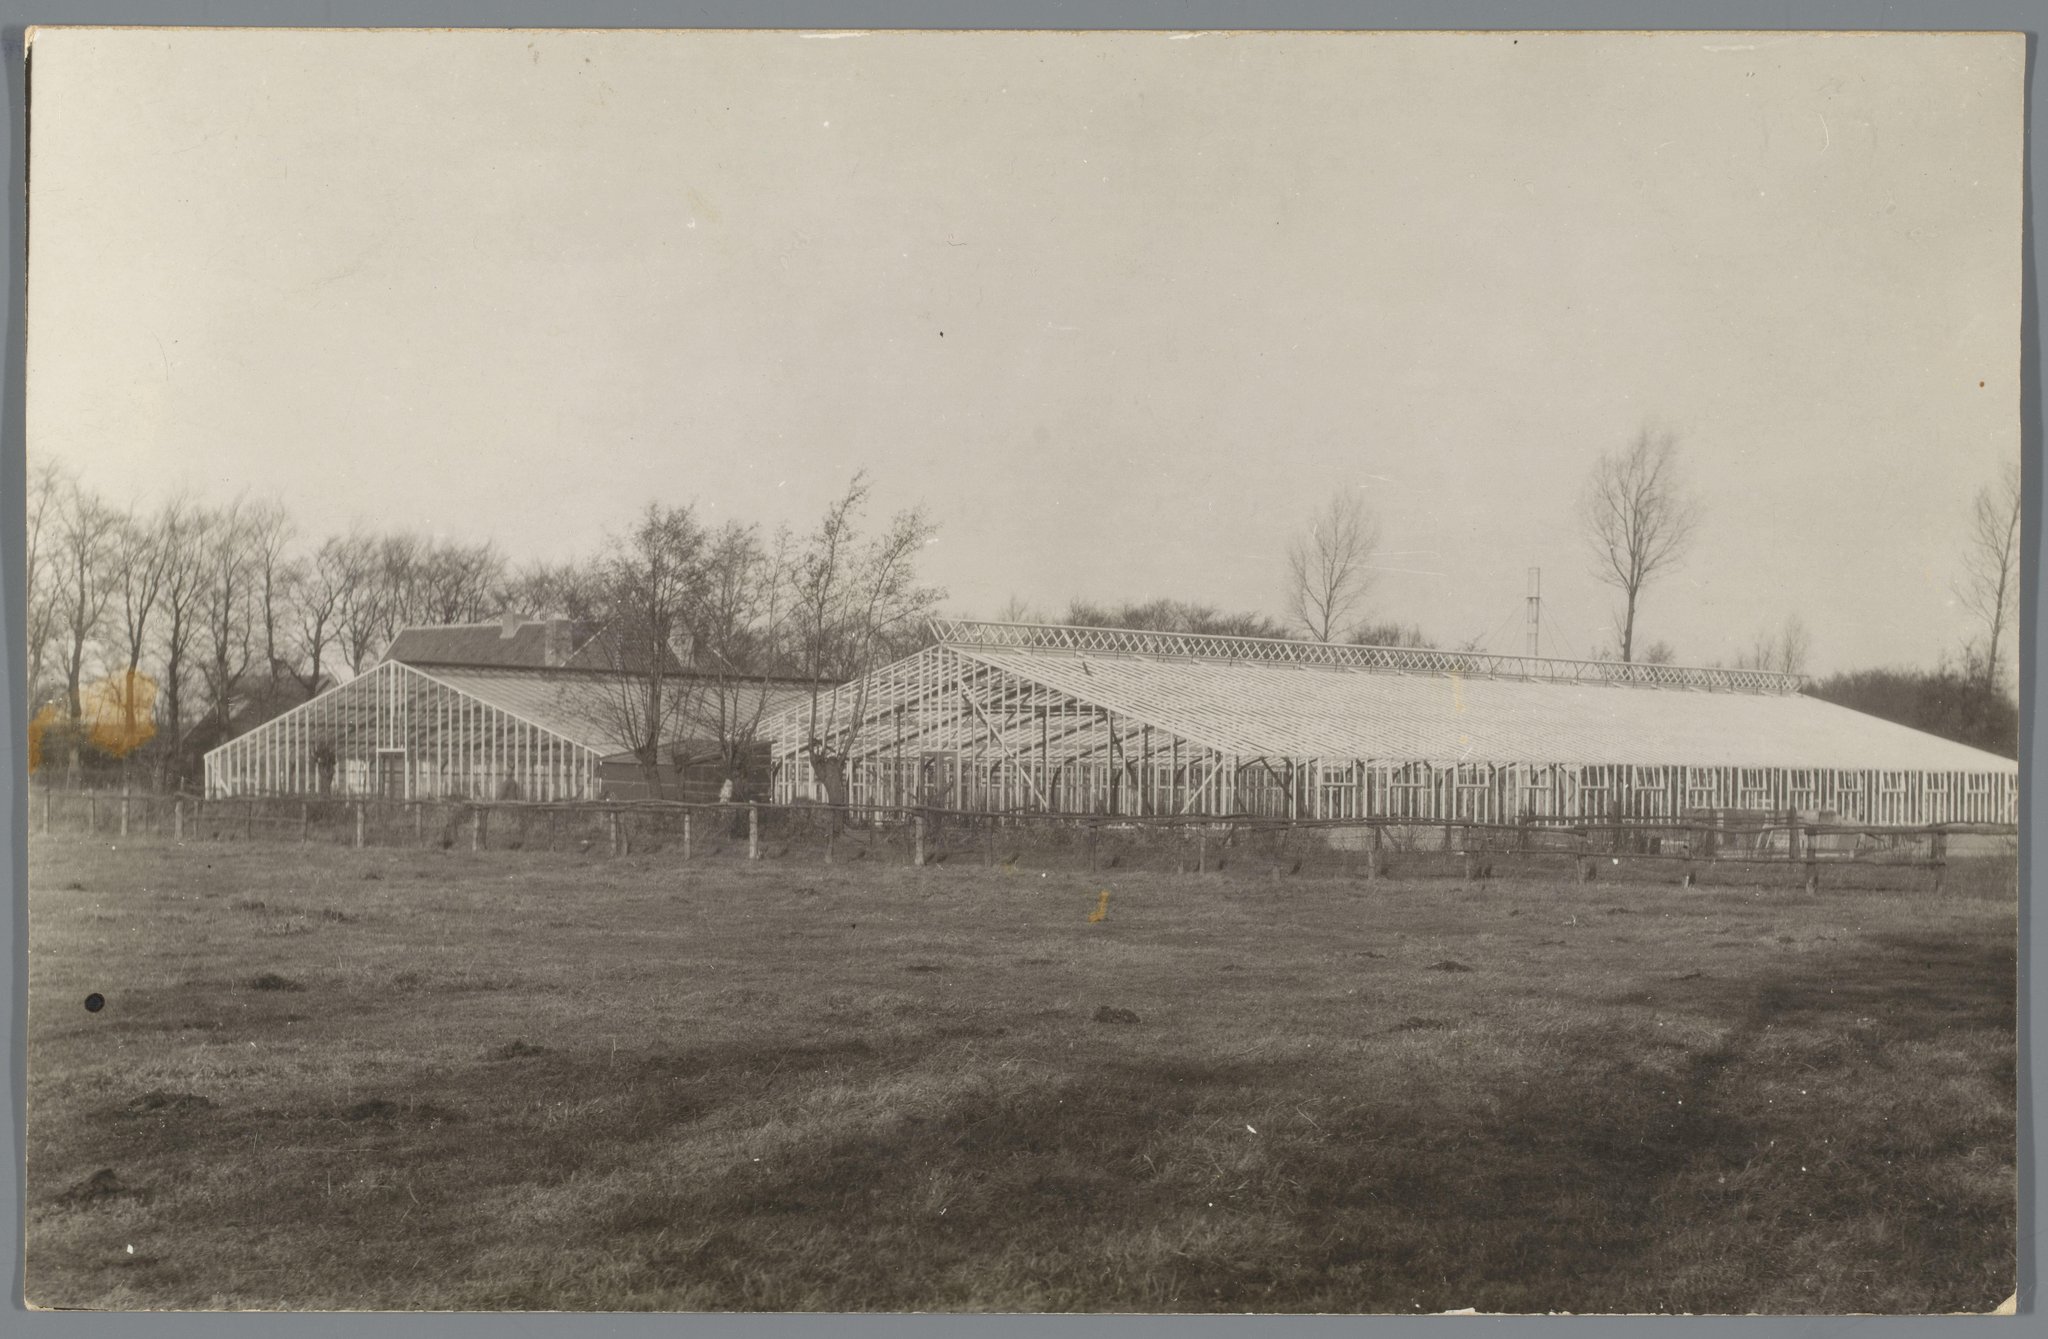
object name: photograph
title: Gezicht op een kwekerij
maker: cornelia hendrika jonker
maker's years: 1874-1924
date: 1920-1970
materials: photographic support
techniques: gelatin silver print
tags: greenhouse, orangery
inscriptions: annotation: ‘Kassen "Capitten"’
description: Op verso regels om te versturen als postkaart.